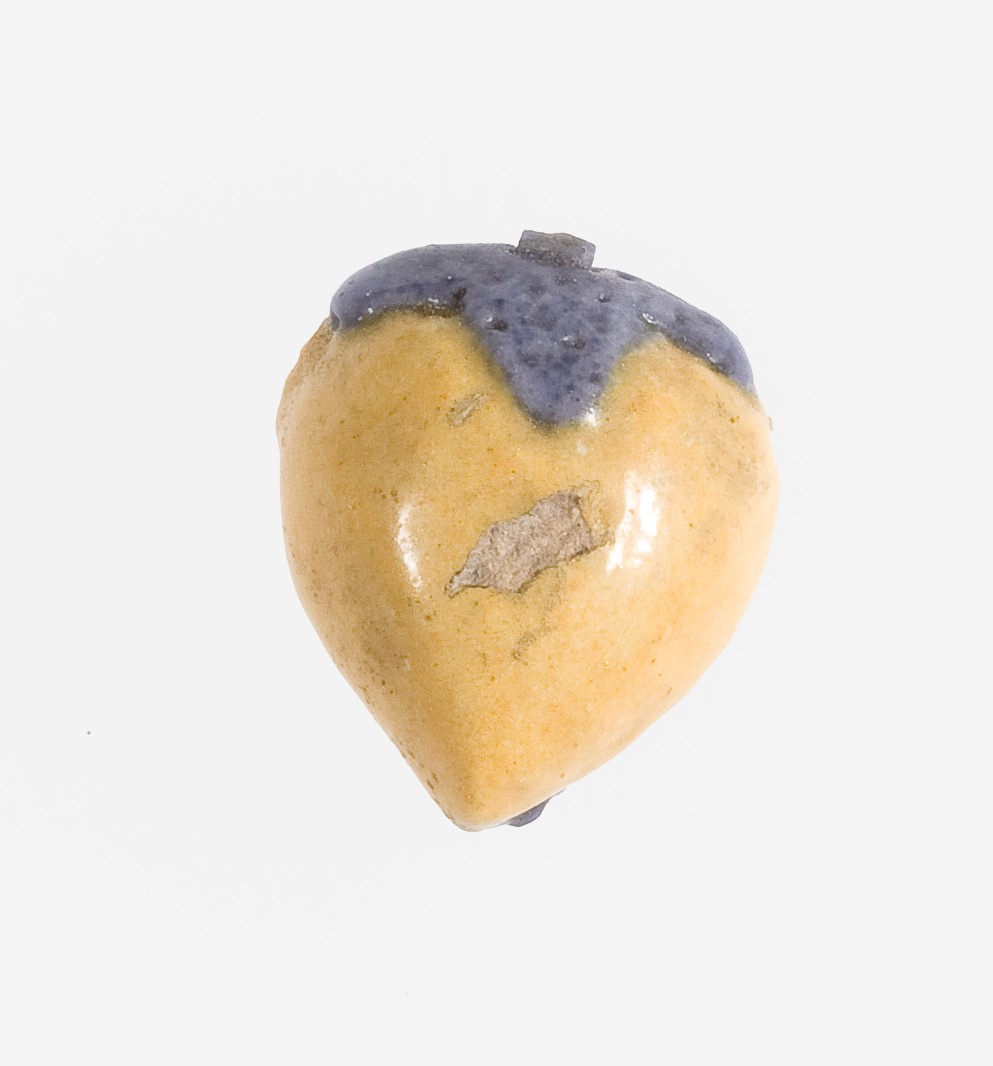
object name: pendant, persea fruit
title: Persea fruit pendant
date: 1390-1352 BCE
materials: faience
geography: egypt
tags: fruit